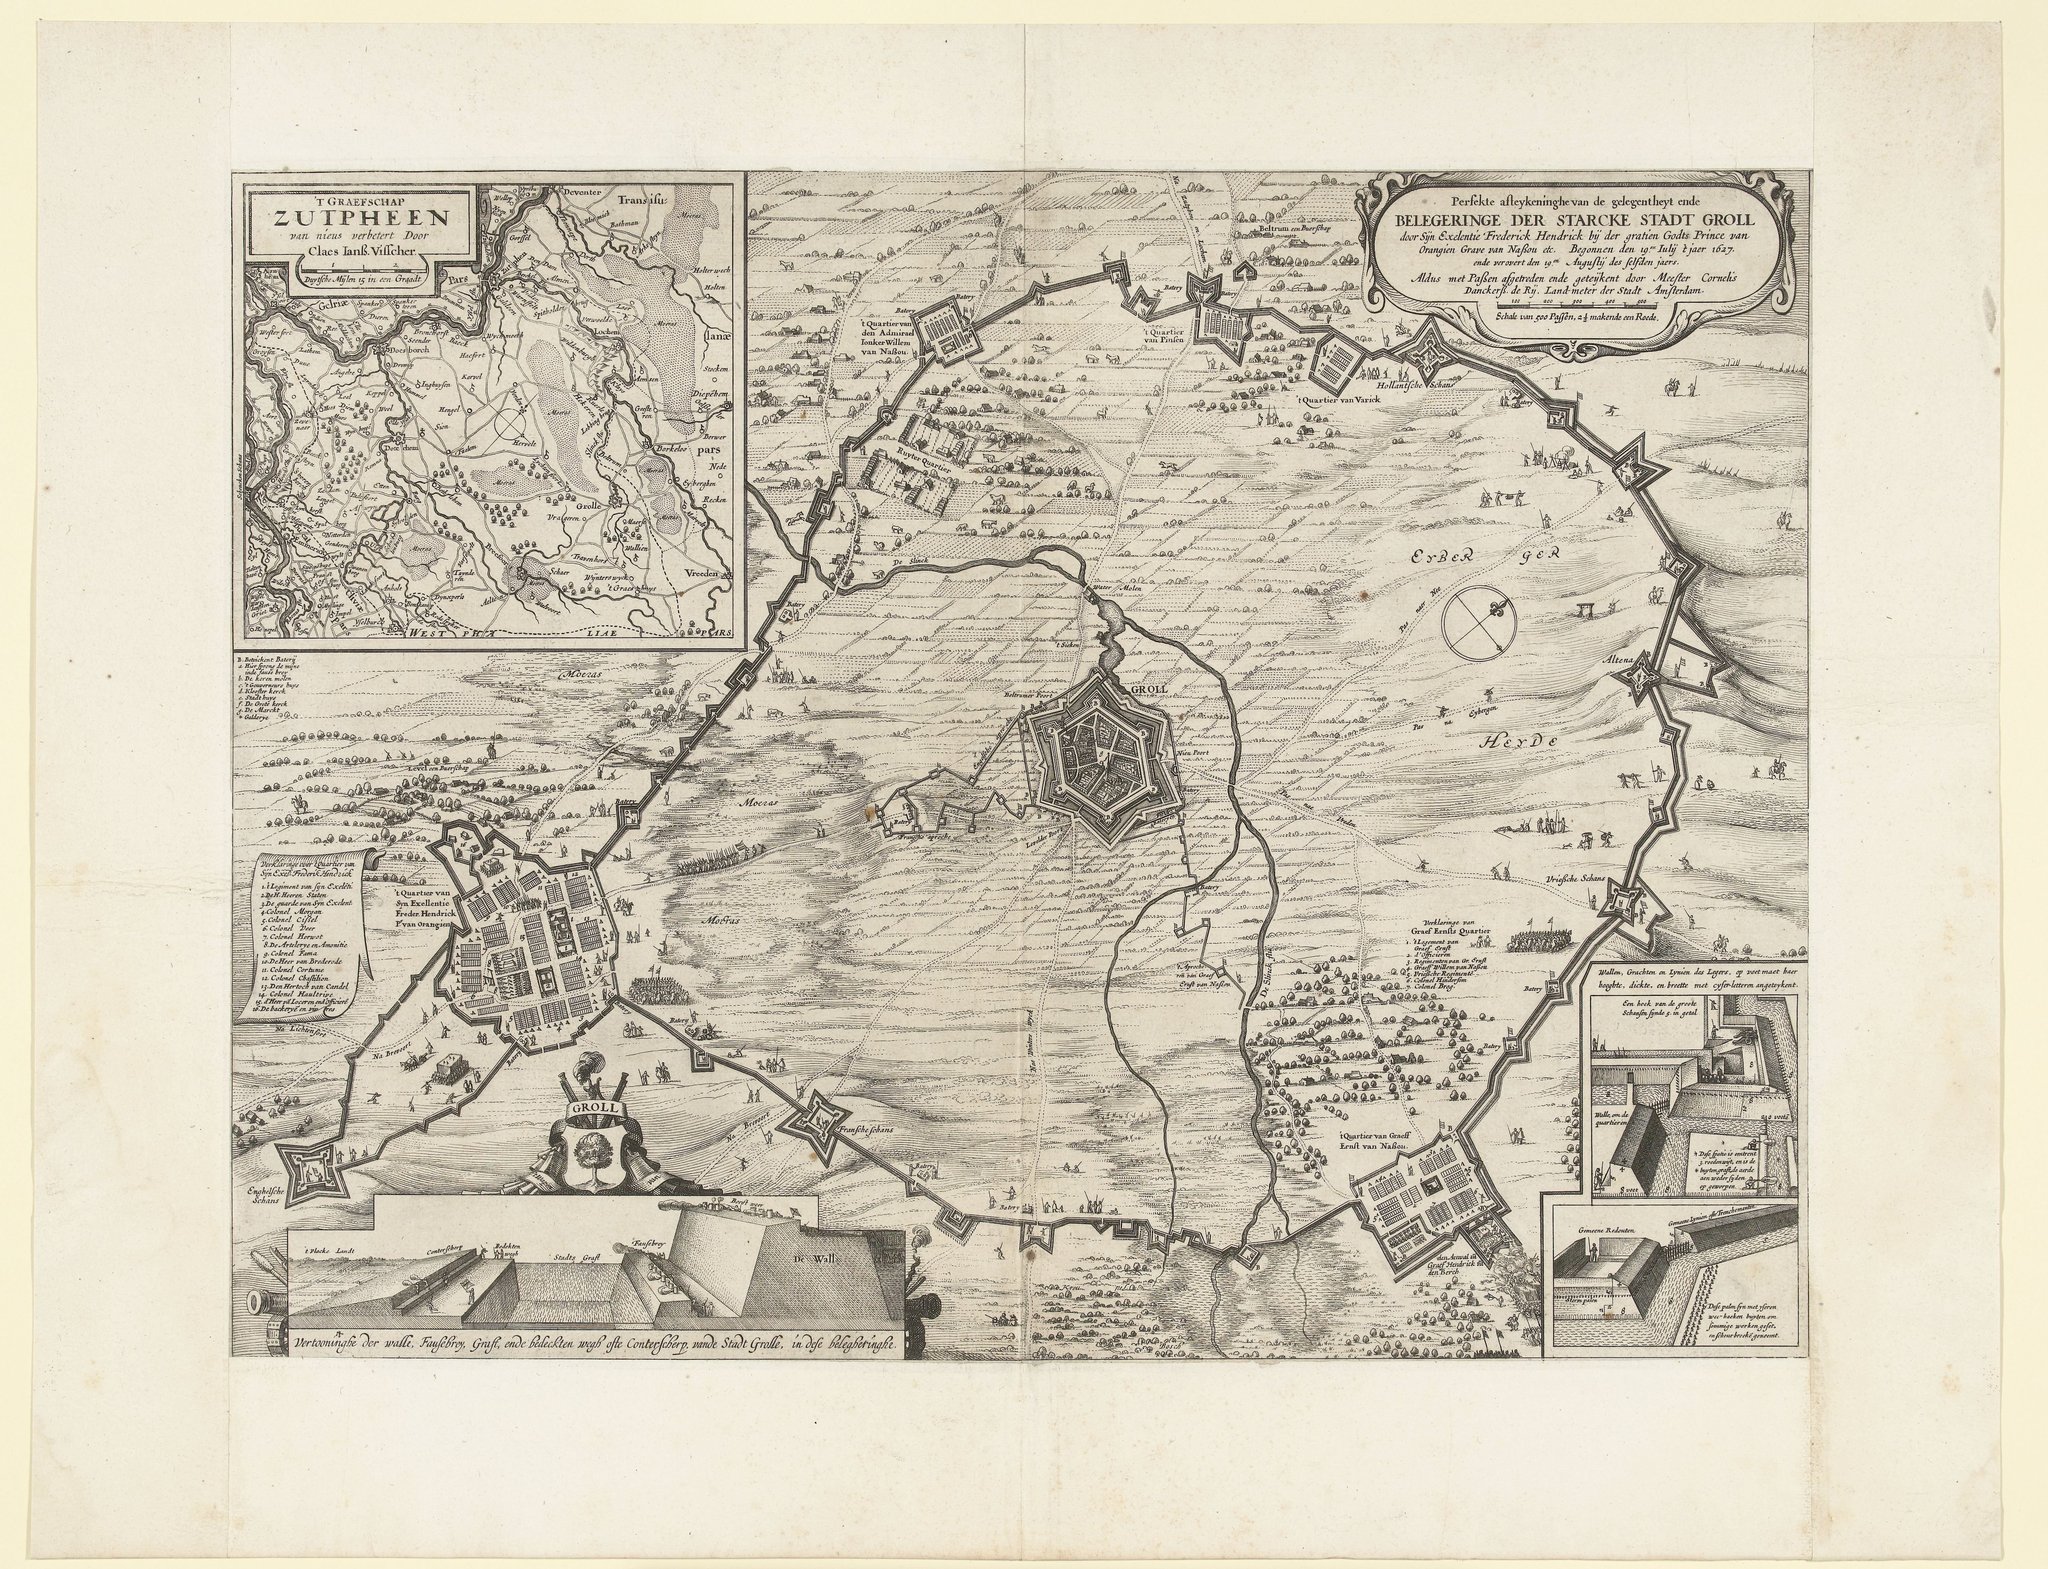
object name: print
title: Beleg van Grol door Frederik Hendrik, 1627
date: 1627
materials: paper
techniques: etching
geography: amsterdam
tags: delft, frederick henry (prince of orange), maps of separate countries or regions, siege, position war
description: Beleg en verovering van de stad Groenlo (Grol) door het Staatse leger onder Frederik Hendrik, 6 juli - 19 augustus 1627. Centraal de stad met het omliggende land en de kwartieren van de belegeraars. Linksboven een inzet met een kaart van het graafschap Zutphen, linksonder een doorsnede van de wallen van de stad. Rechtsboven cartouche met titel en een schaalstok: Schale van 500 passen, 2.5 makende een roede. Rechtsonder nog twee details van de wallen en redoutes aangelegd door het leger. Links de legenda 1-16 van het legerkamp van Frederik Hendrik.